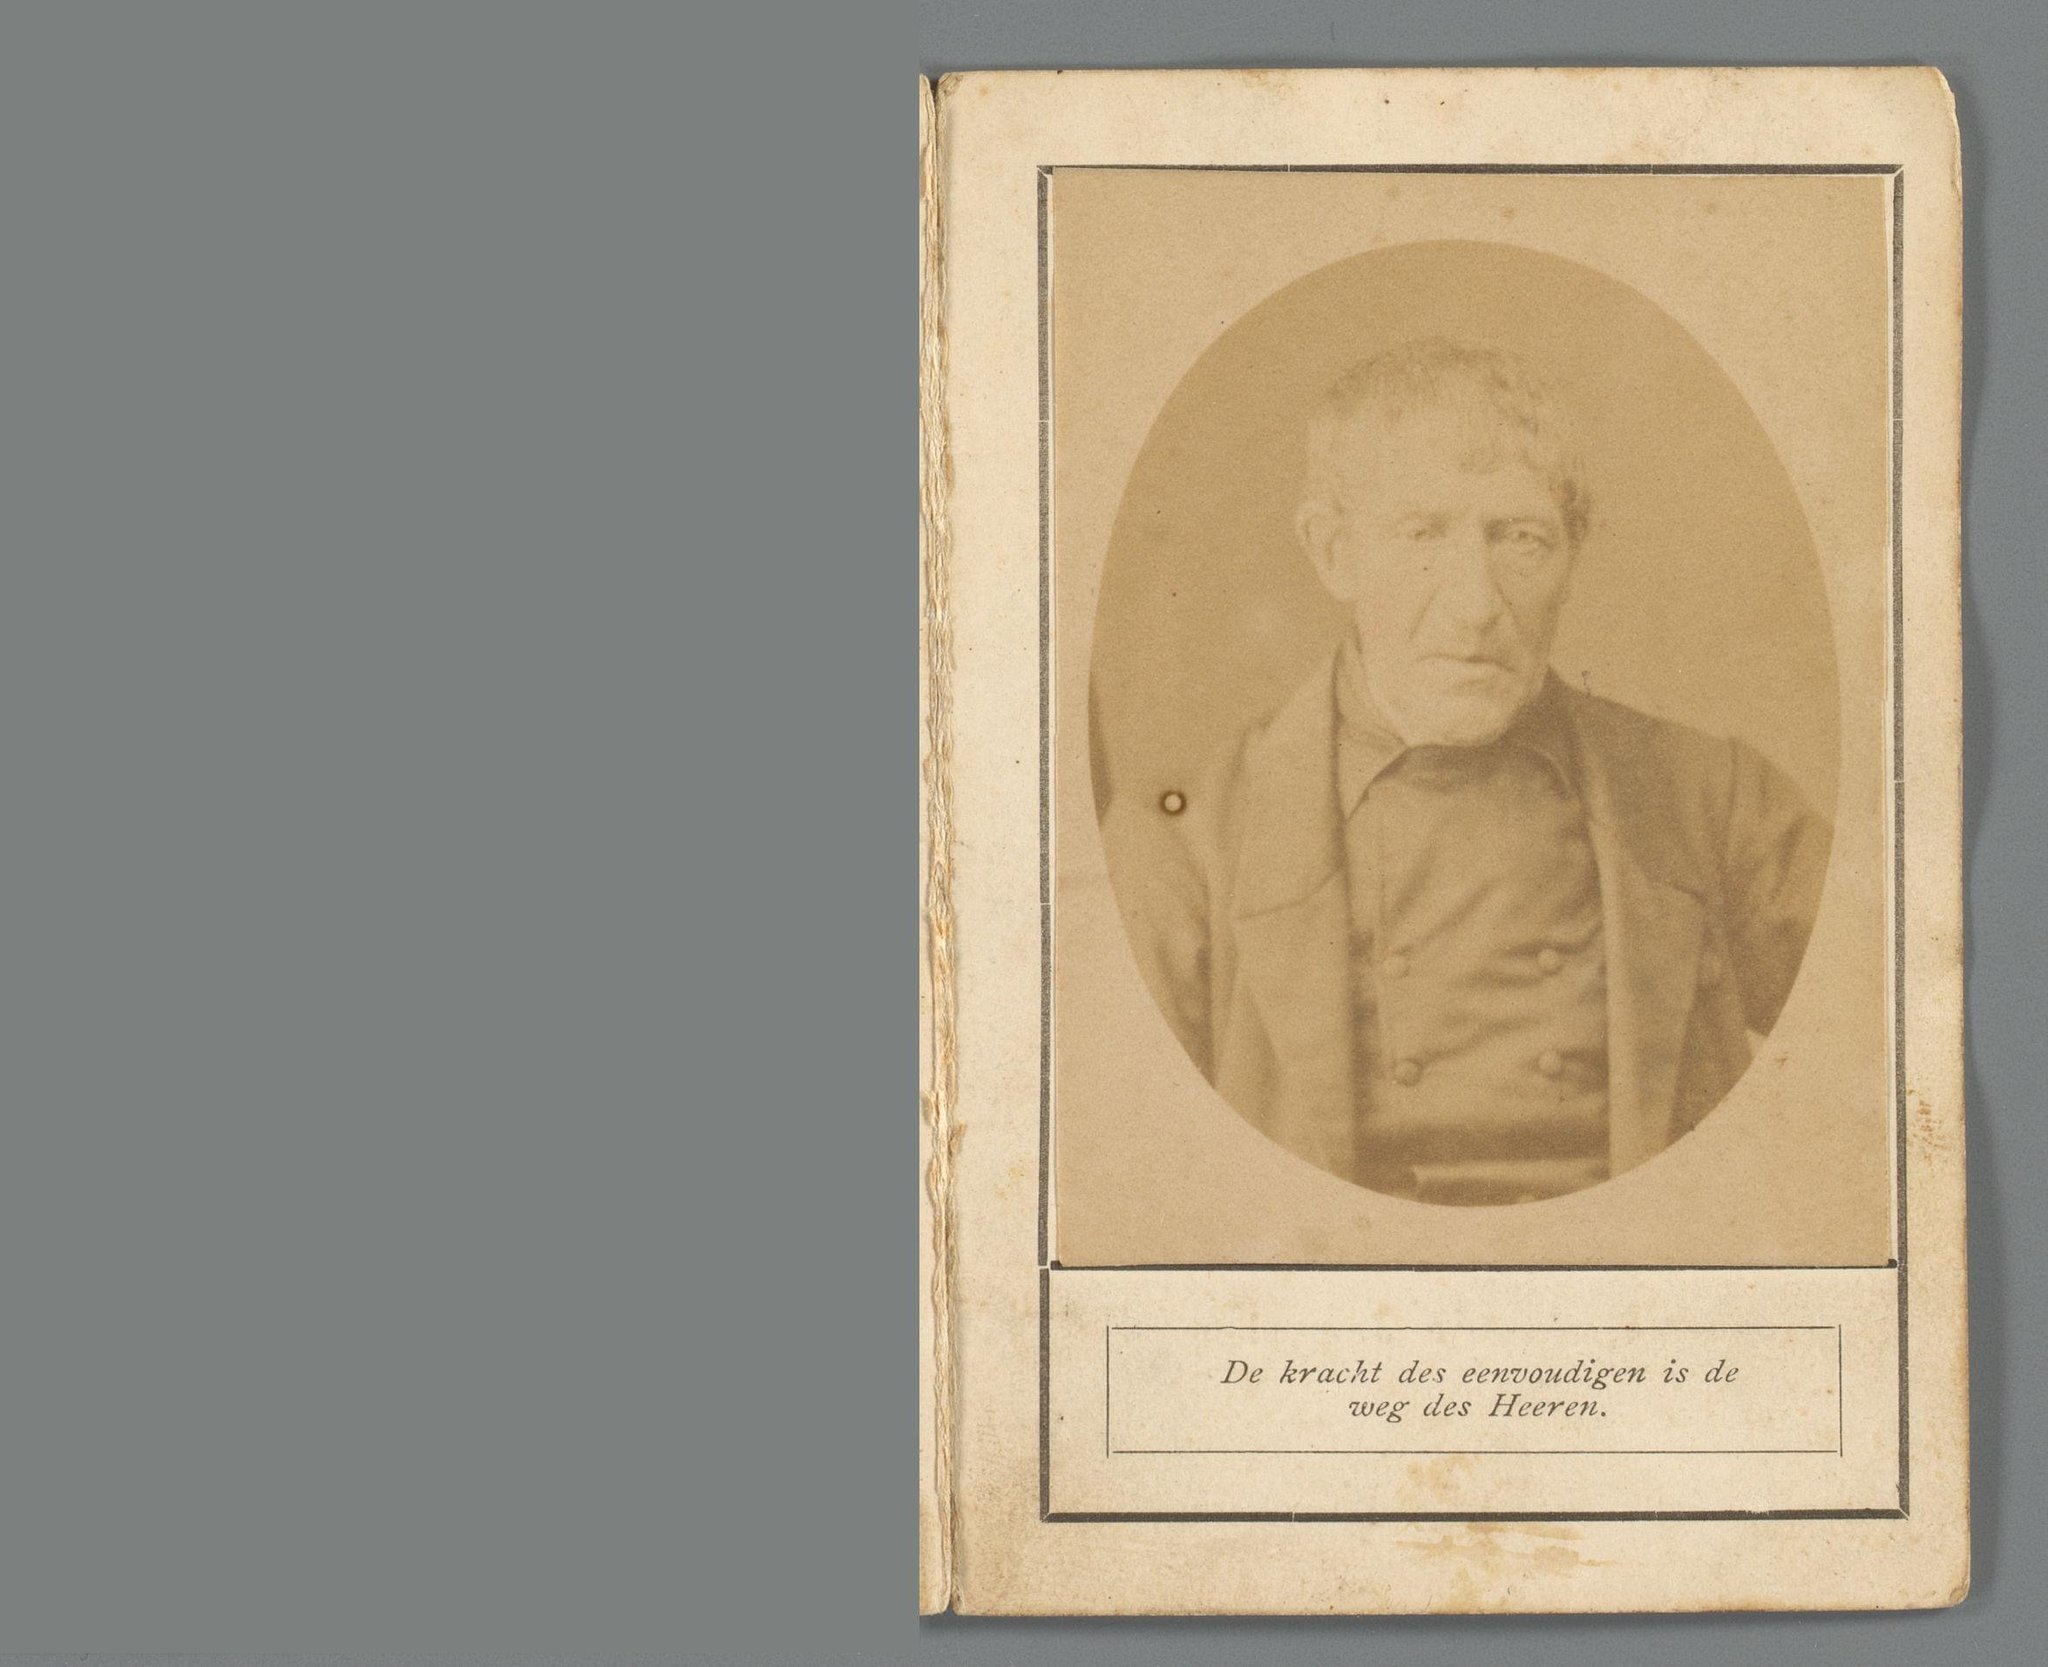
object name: photograph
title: Portret van Wilhelmus van Hout op bidprent; helft van een dubbele bidprent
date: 1887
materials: paper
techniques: albumen print, letterpress printing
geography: cuijk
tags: historical persons, old man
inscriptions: inscription: ‘De ktracht des eenvoudigen is de/ weg des Heeren.’, inscription: ‘In de gebeden der geloovigen wordt aanbevolen (...) Onze Vader... Wees gegroet...,/ R.I.P./ Typ. Jos. J. van Lindert, te Cuyk.’